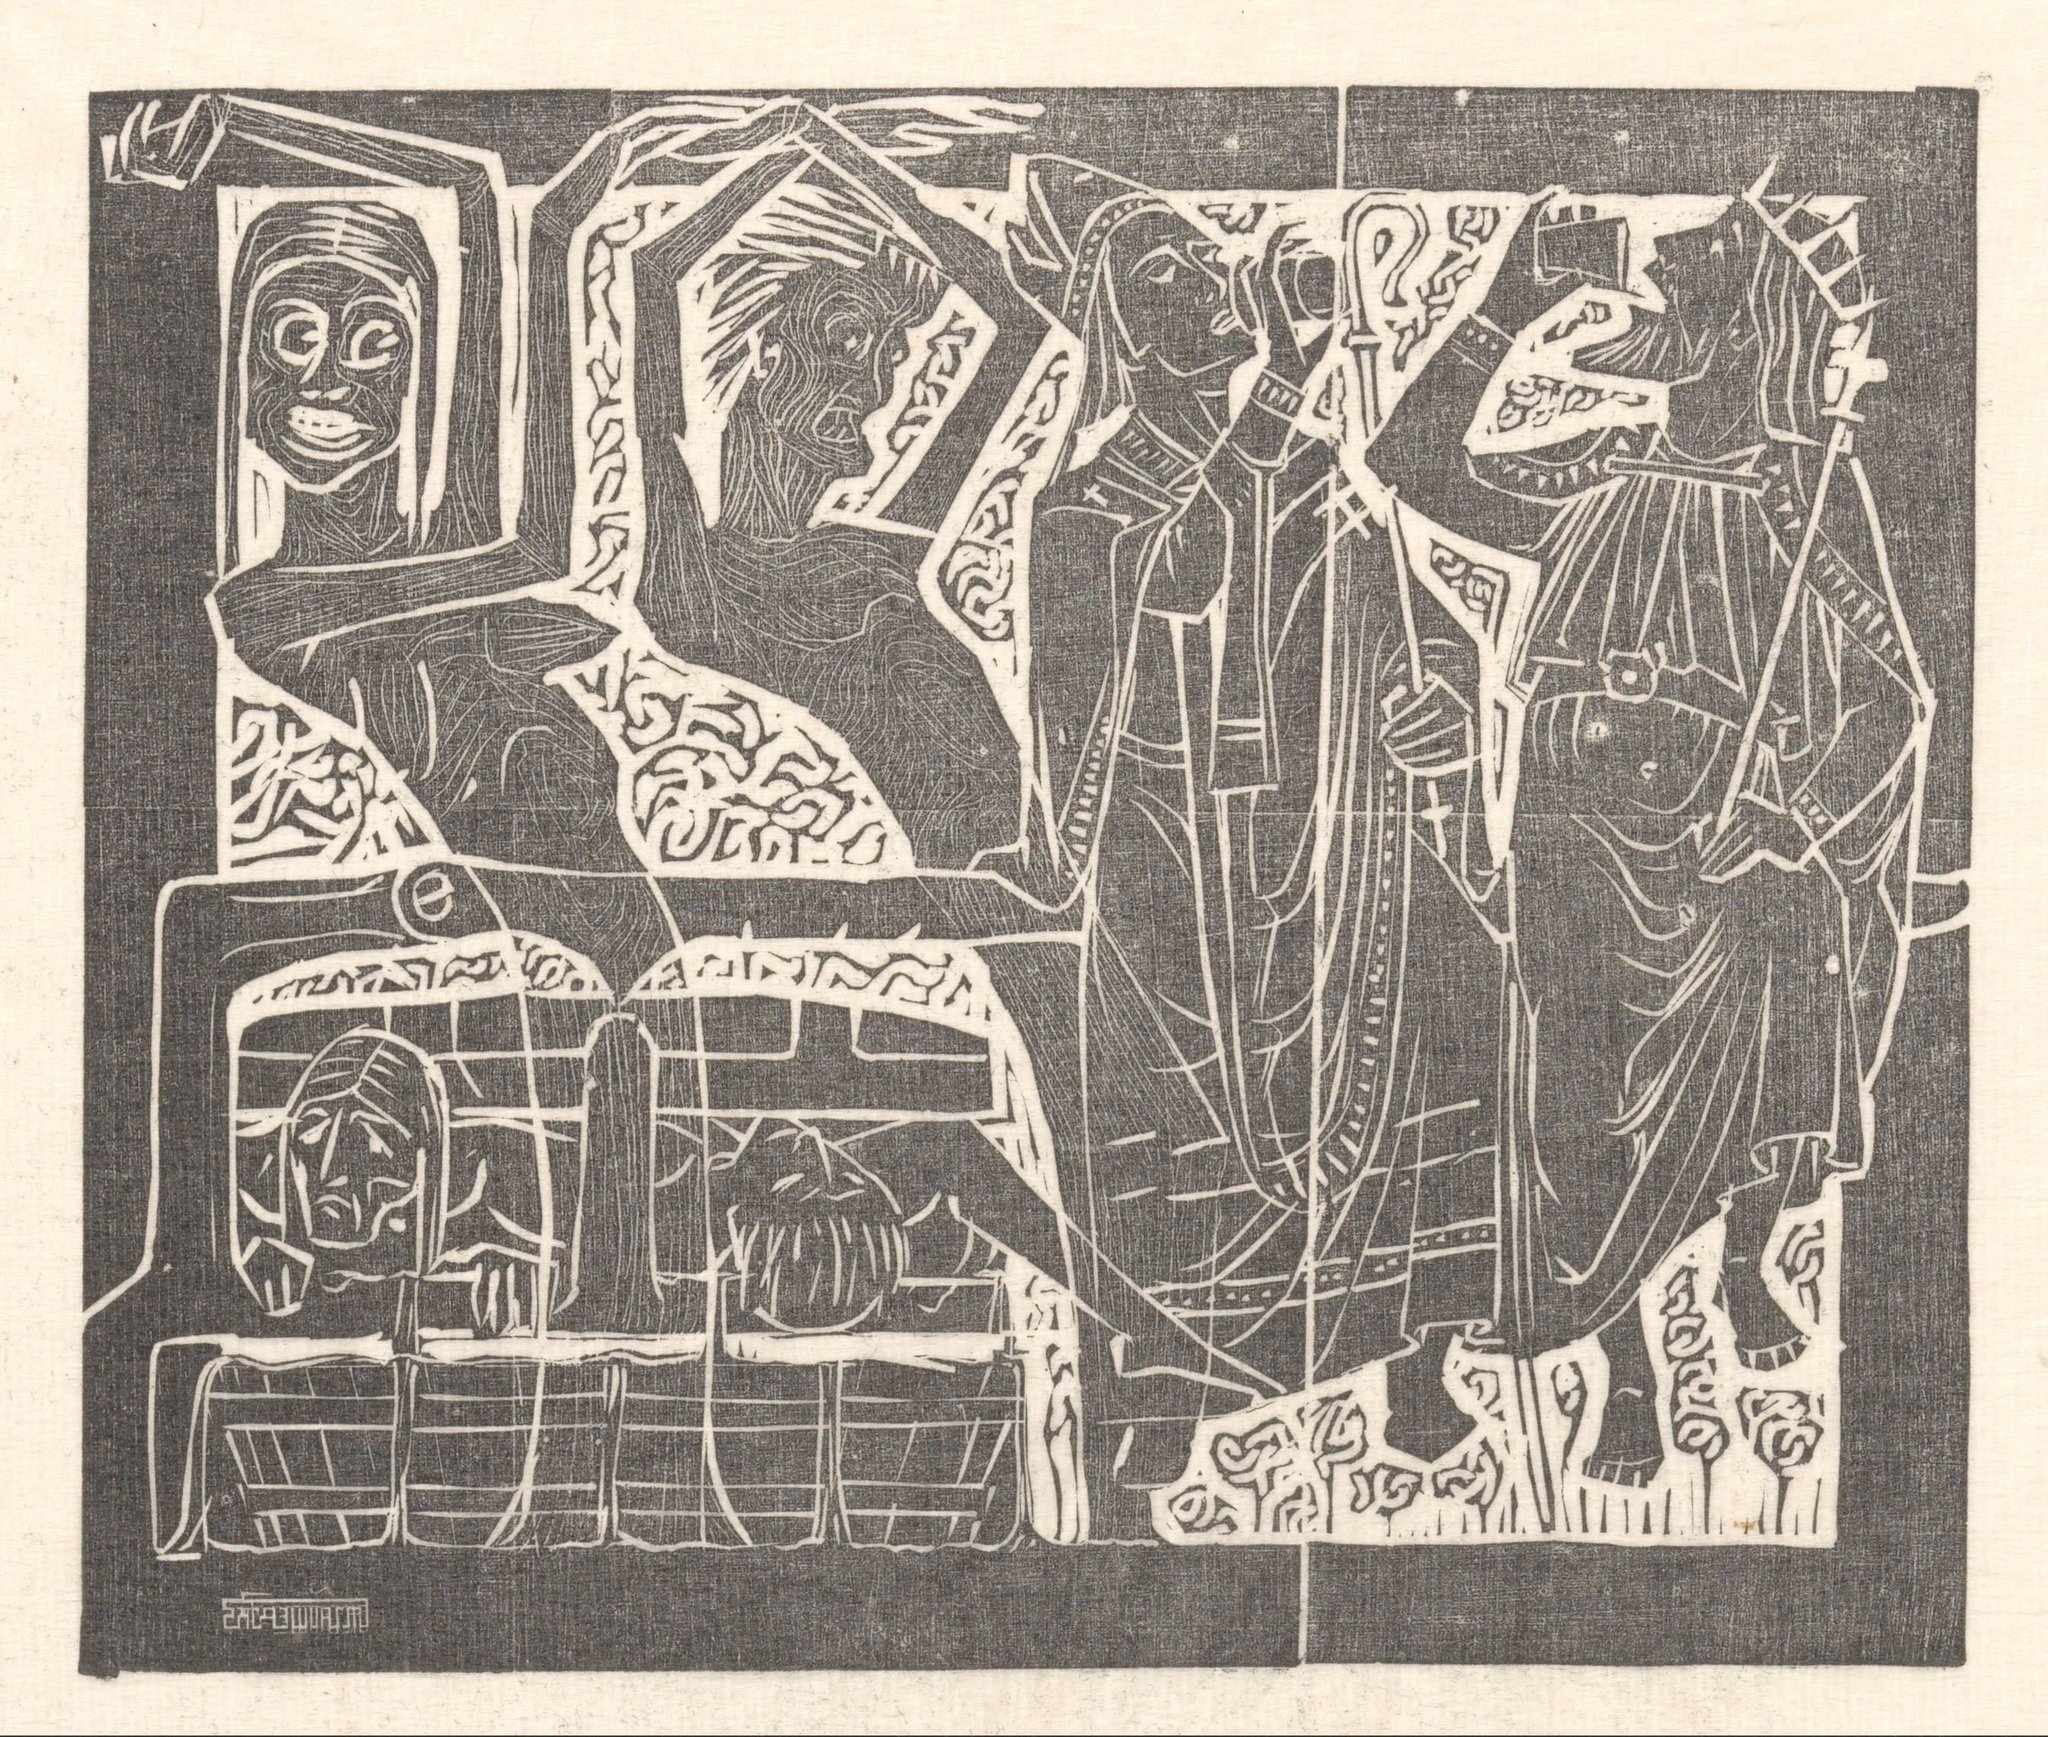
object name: print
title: Wijnpers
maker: mathieu lauweriks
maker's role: designer, draughtsman, print maker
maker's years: 1864-1932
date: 1894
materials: paper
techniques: woodcut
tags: personifications of countries, nations, states, districts, etc., wine-press, the church personified, 'ecclesia', usually with chalice and banner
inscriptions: collector's mark: Lugt 2228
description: Links een wijnpers waarmee het bloed van twee mensen wordt uitgeperst. Bij de pers twee dansende naakte figuren. Rechts staan een bisschop en een koning, als personificaties van de Kerk en de Staat, te drinken.